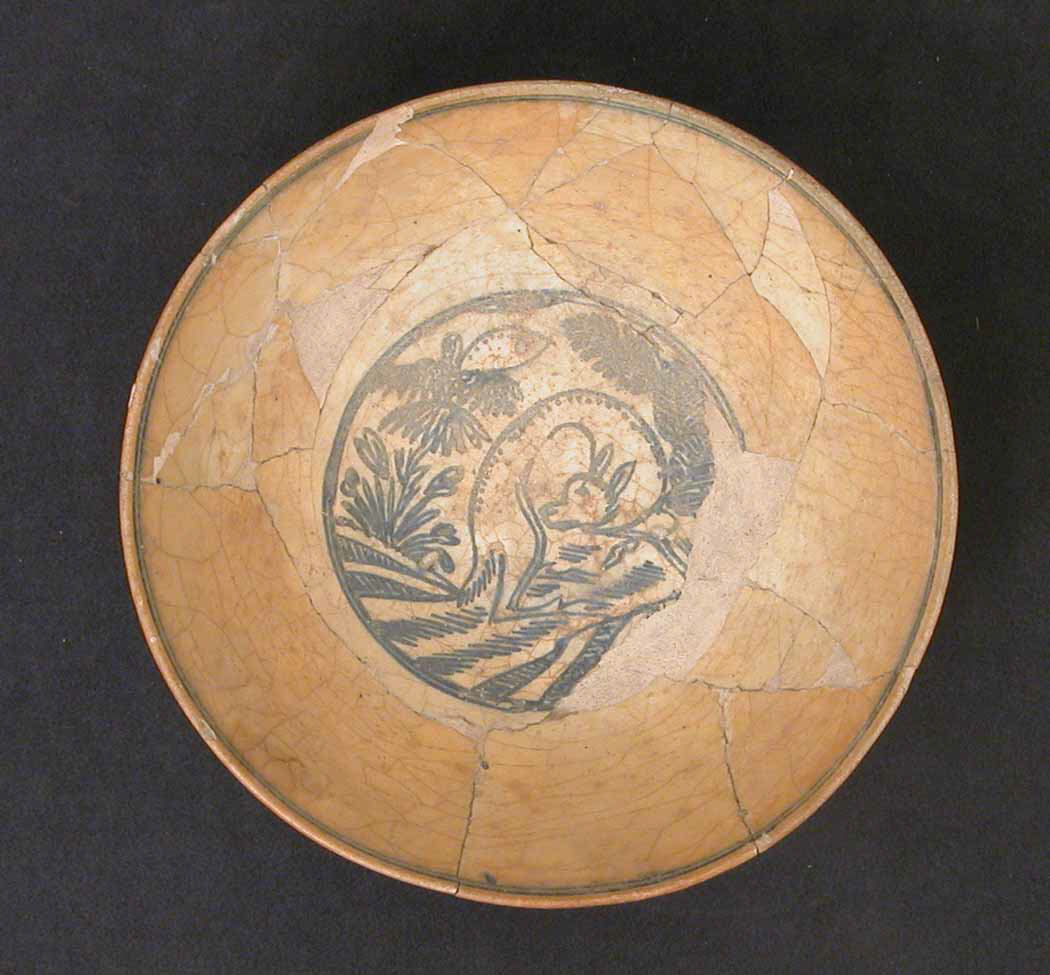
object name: bowl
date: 1667-1733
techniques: glazing, painting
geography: iran